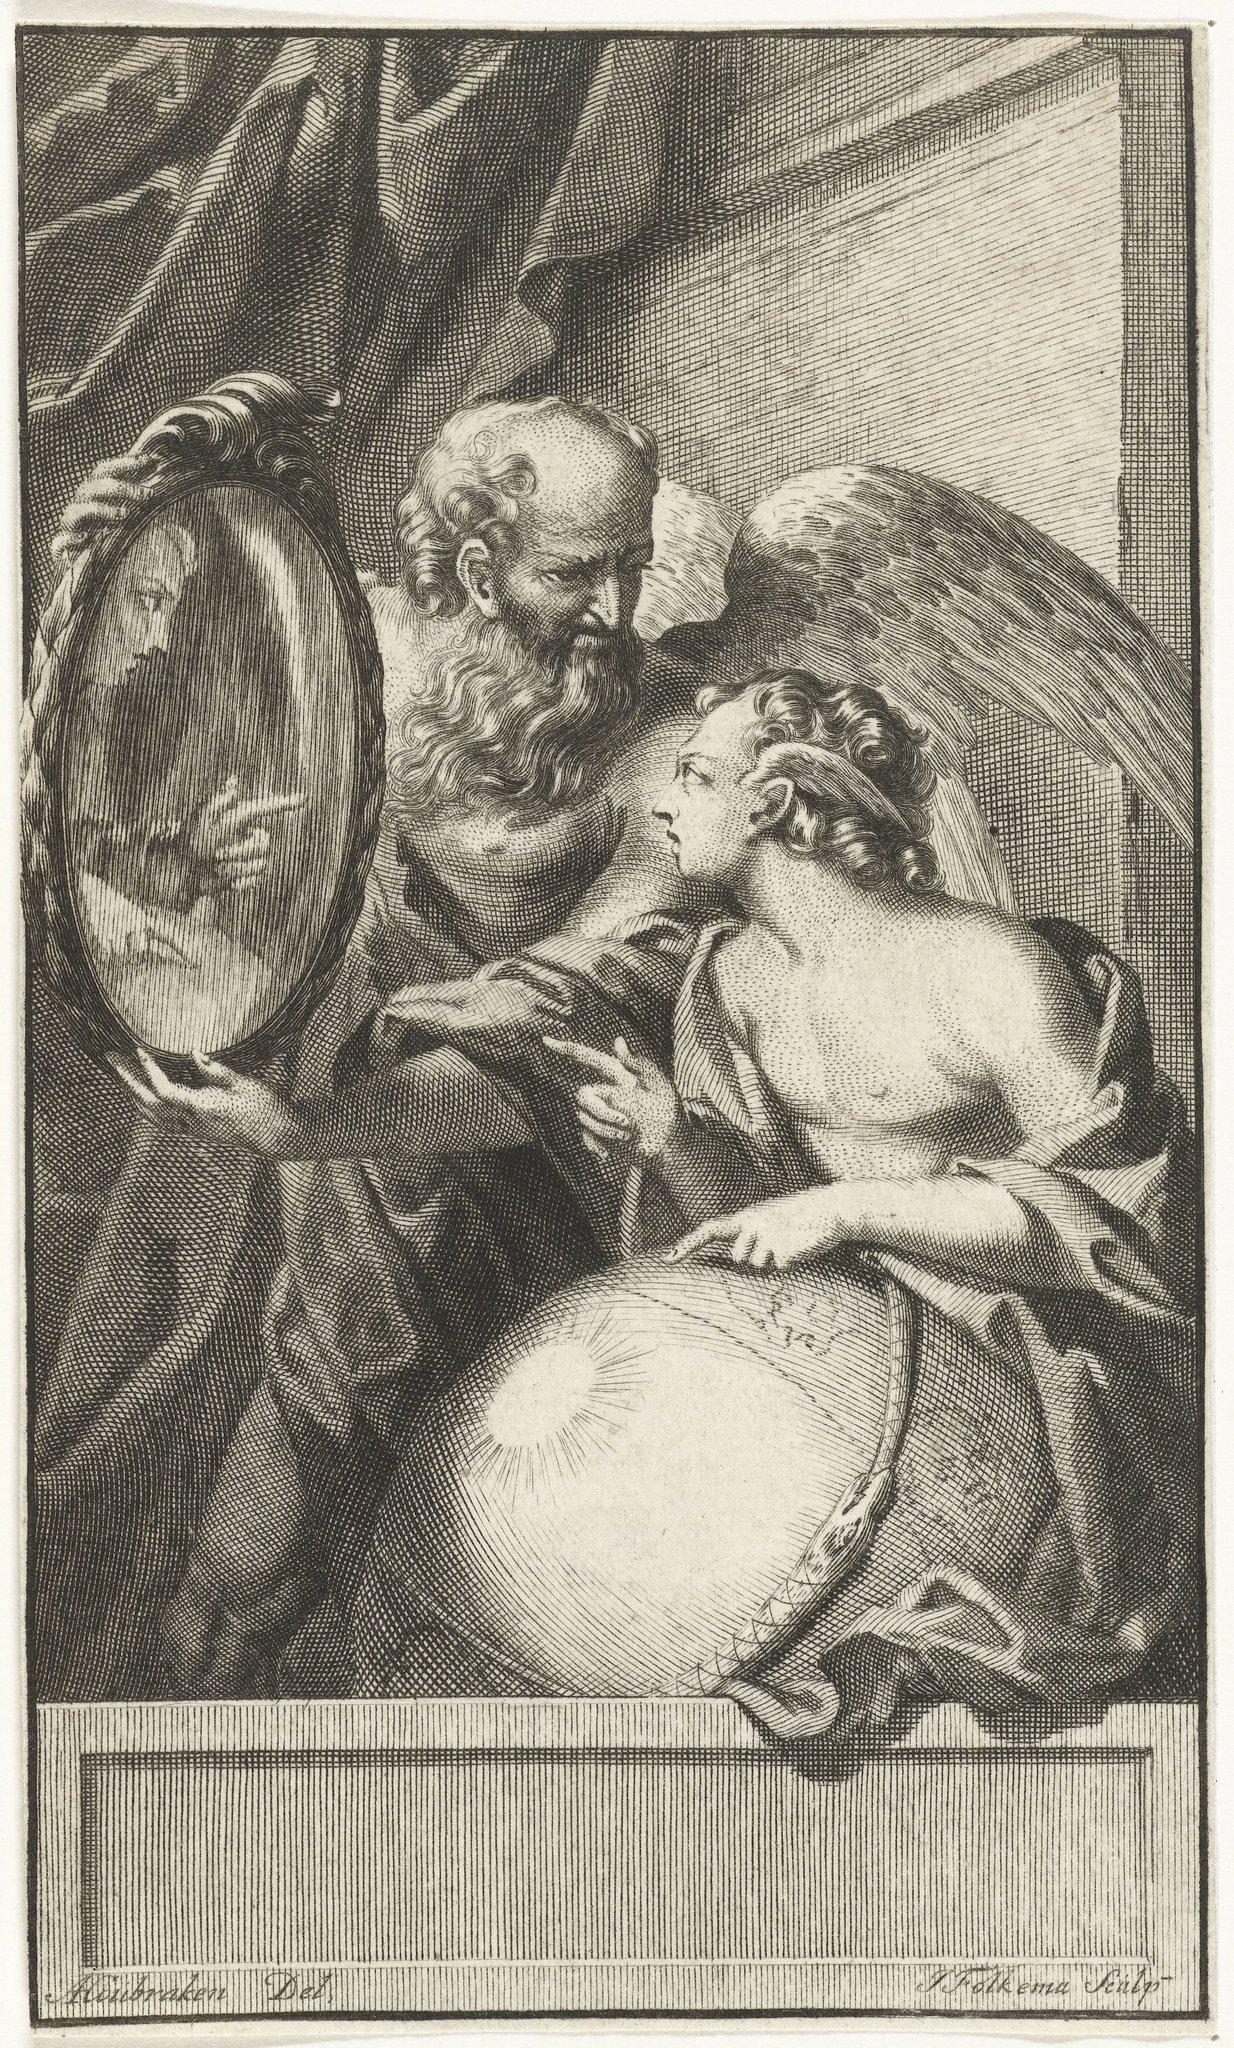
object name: print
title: Vader Tijd houdt een spiegel voor aan een jonge vrouw met een wereldbol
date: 1720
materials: paper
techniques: engraving, etching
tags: mirror, father time, man with wings and scythe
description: Vader Tijd houdt een spiegel voor aan een jonge vrouw met een wereldbol. Losse druk van de centrale voorstelling in de titelprent voor het Tafereel der Dwaasheid, 1720.